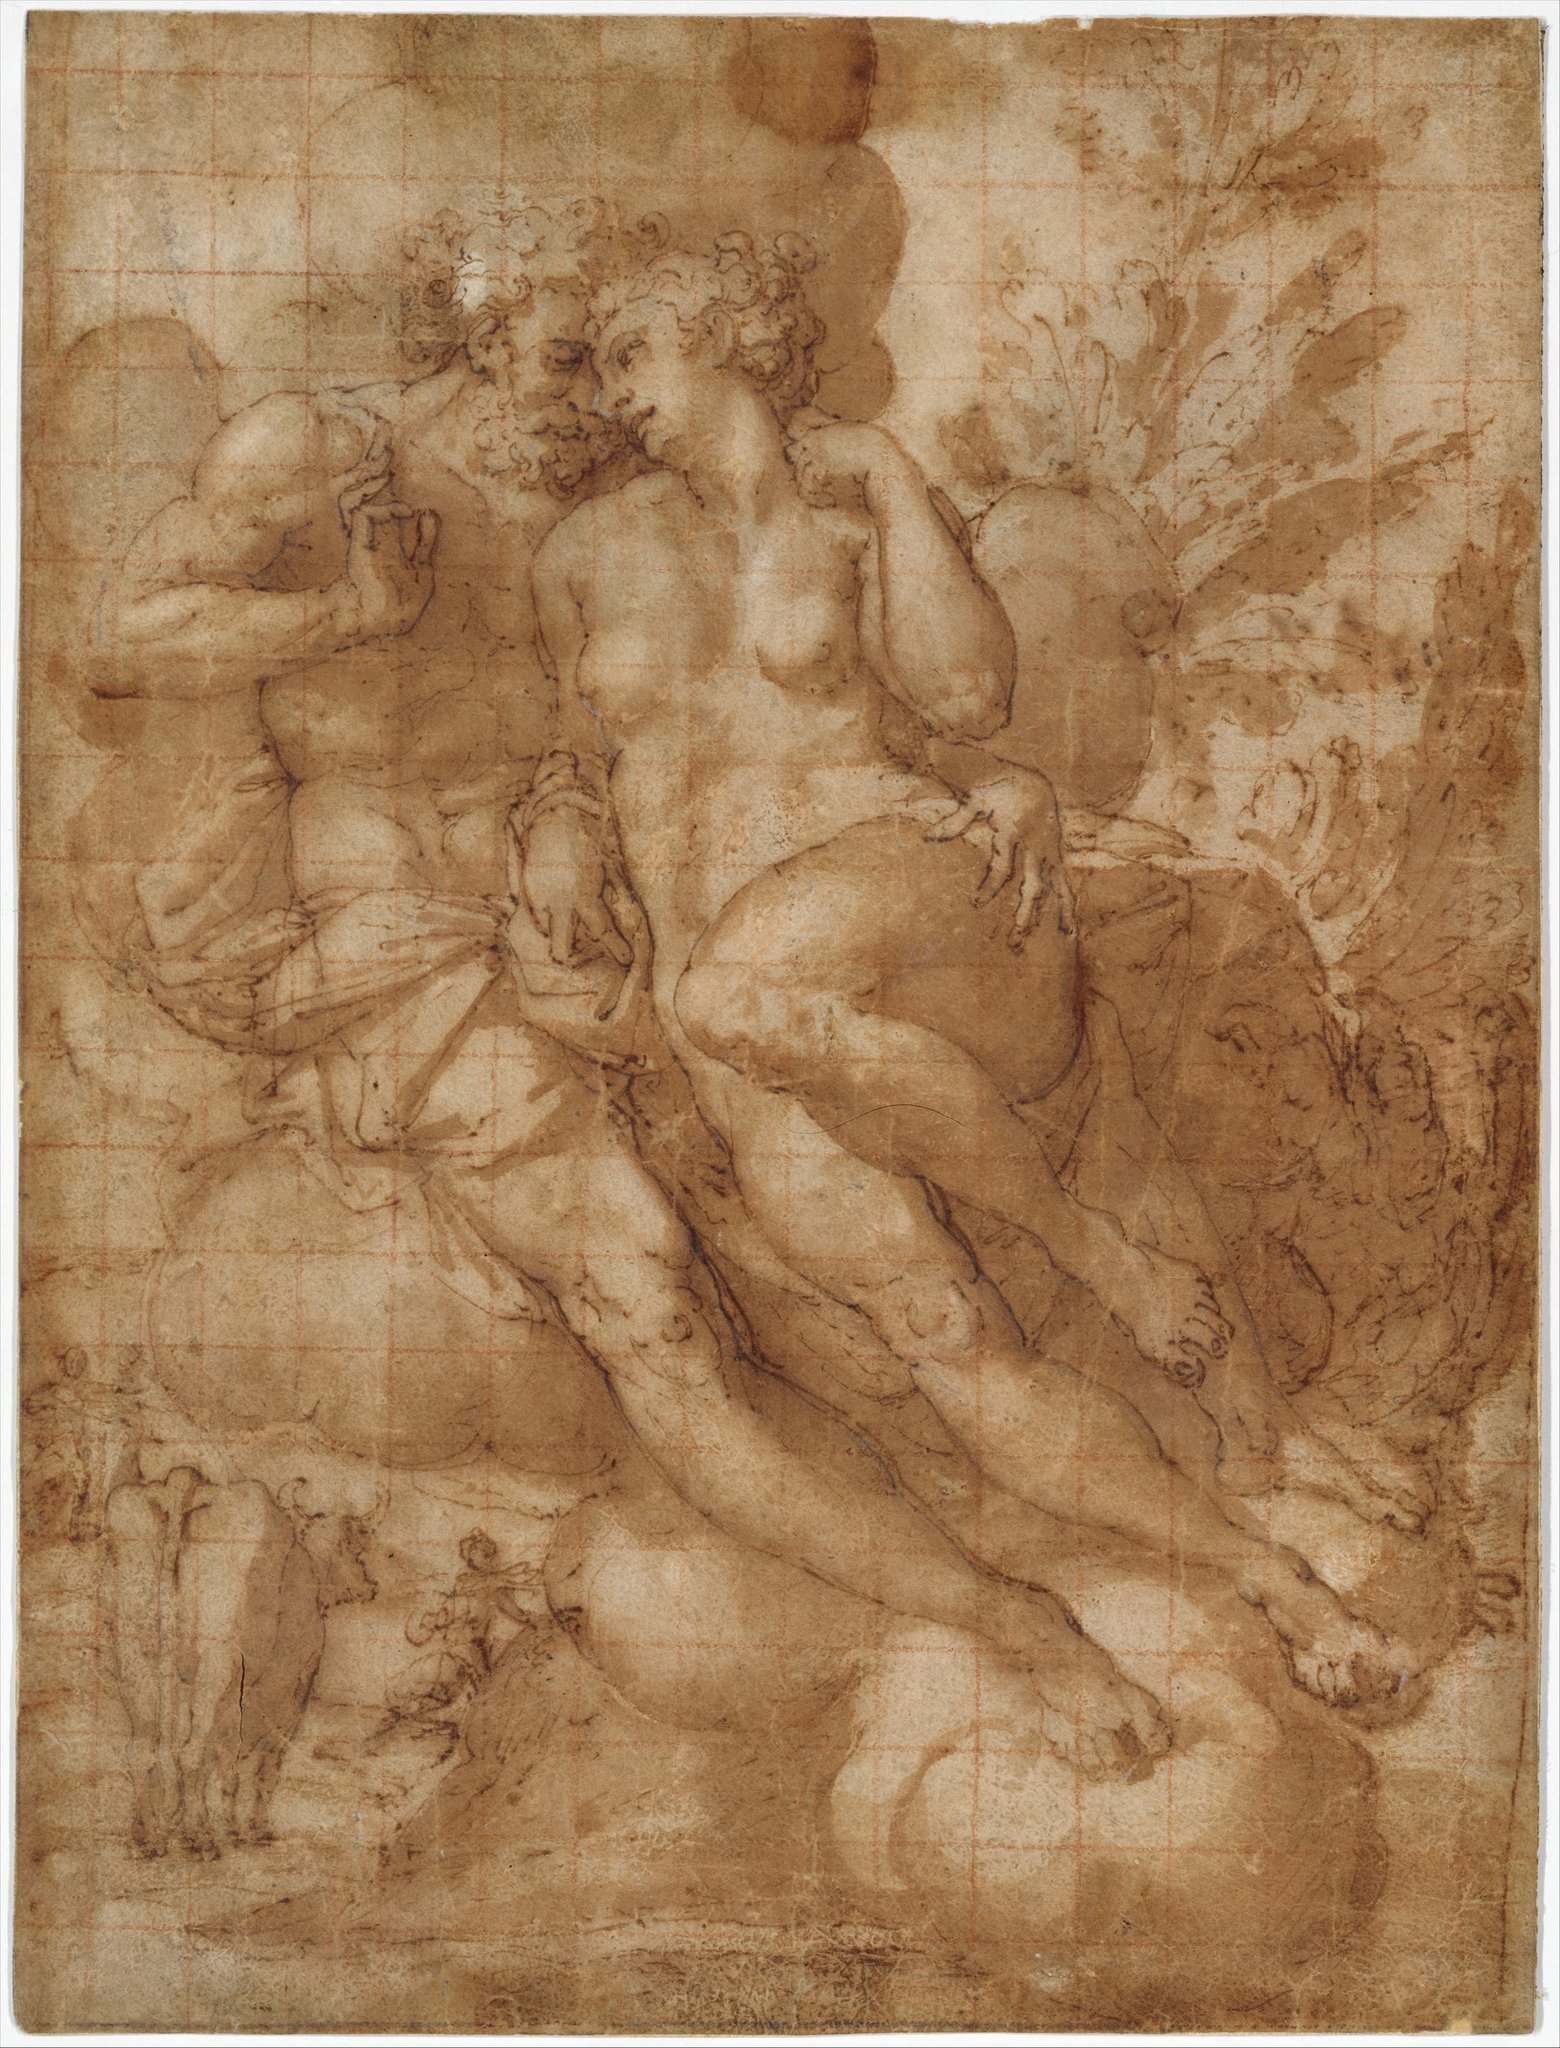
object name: drawing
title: Jupiter and Io (recto); sketch of a male figure stabbing himself in the chest (verso)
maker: francesco salviati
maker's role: artist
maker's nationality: italian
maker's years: 1510-1563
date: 1534-1566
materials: chalk, ink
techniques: brush, pen, drawing, wash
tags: female nudes,jupiter